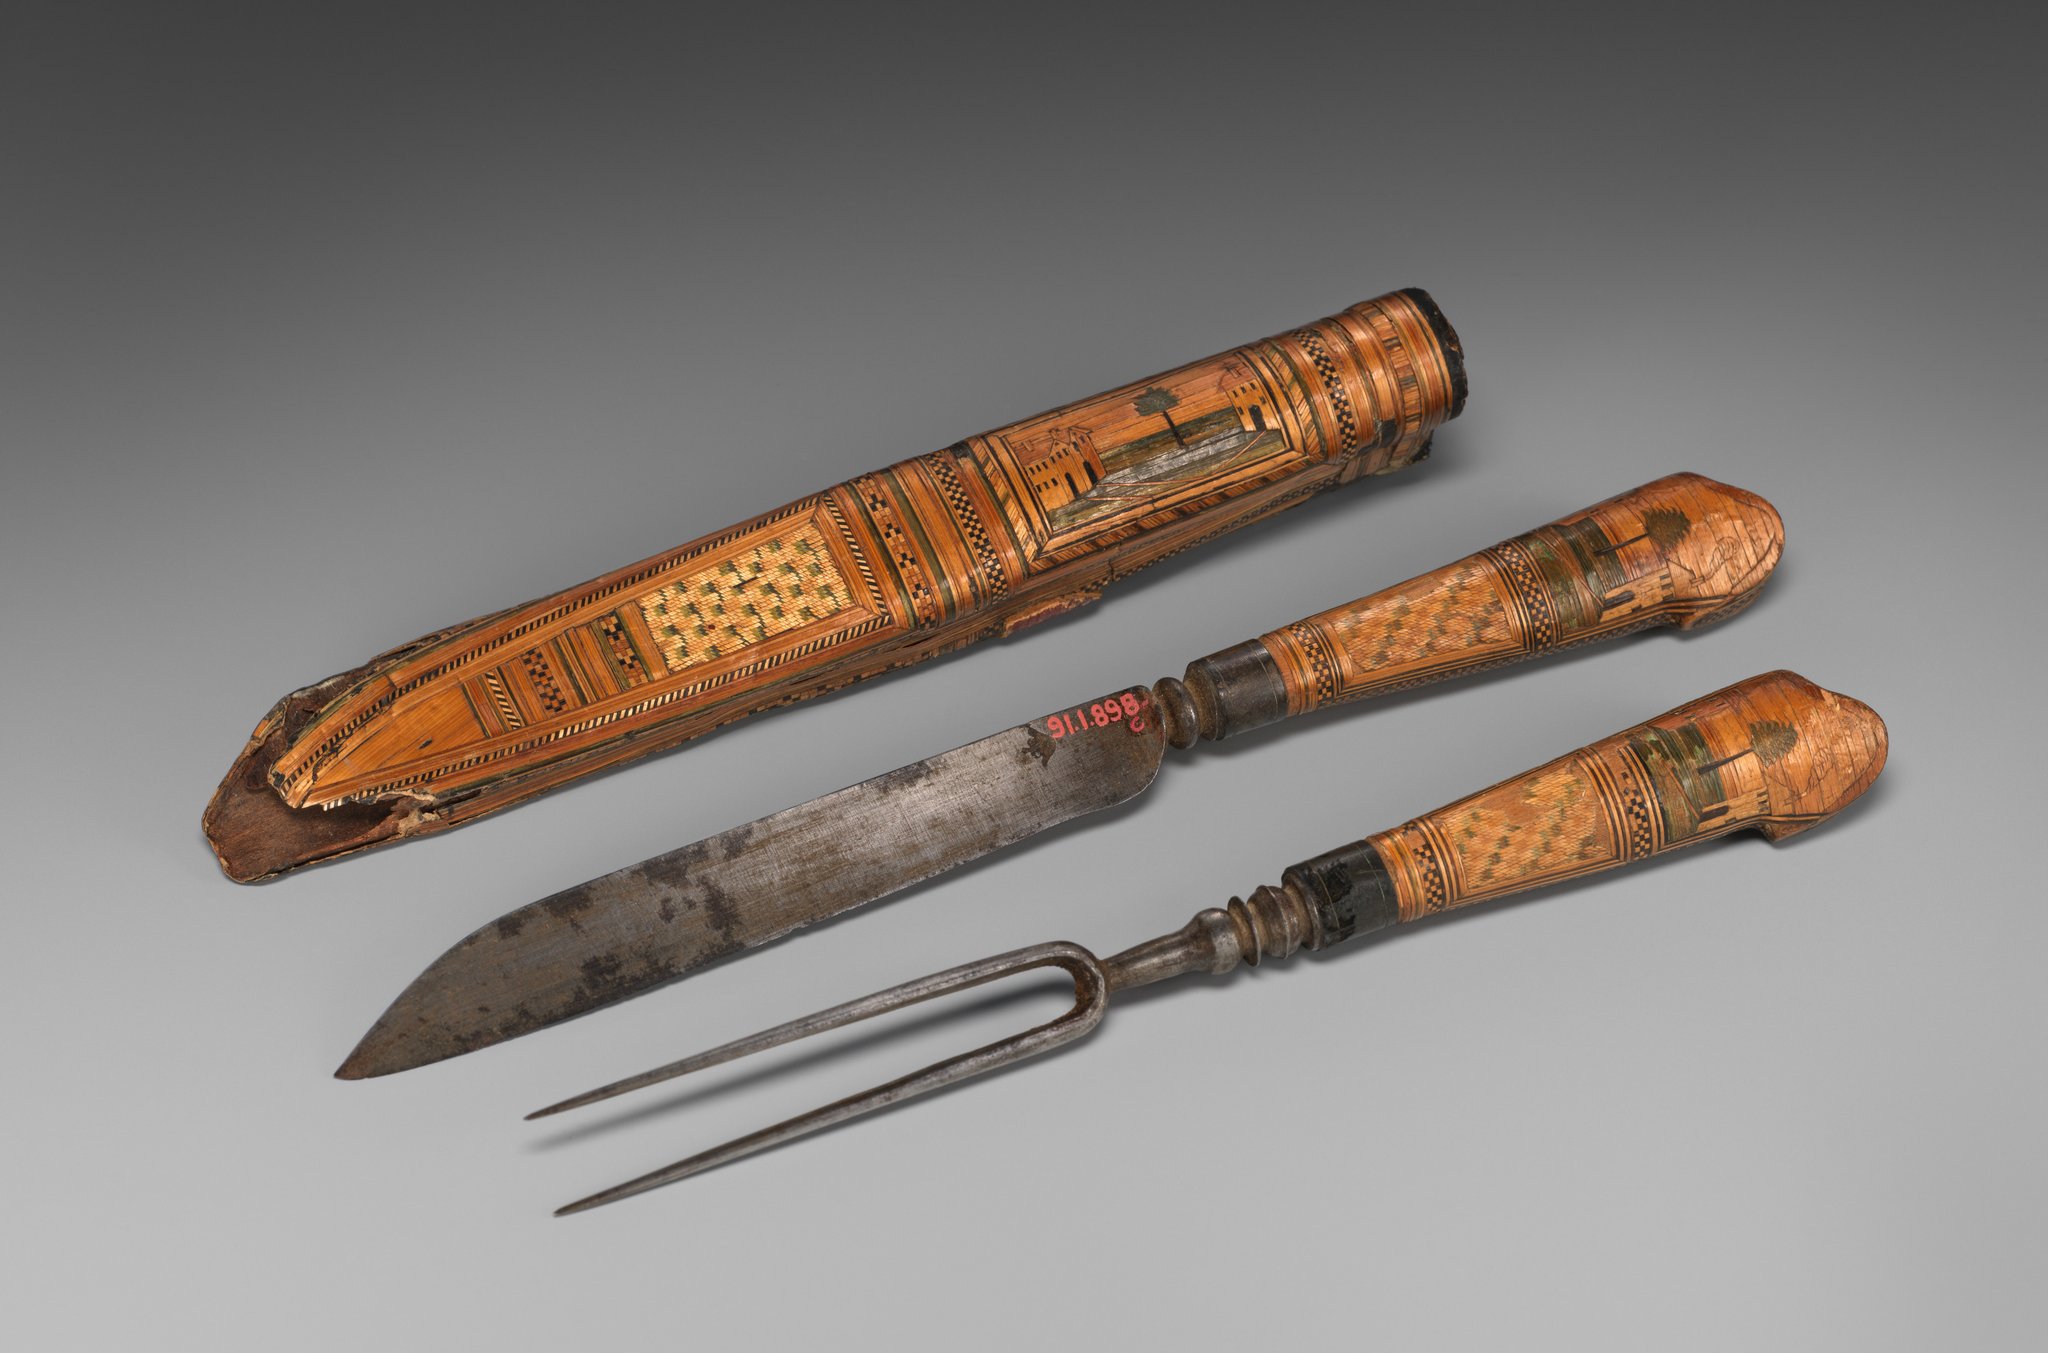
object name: knife, fork and scabbard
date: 1701-1900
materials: steel, fiber, wood